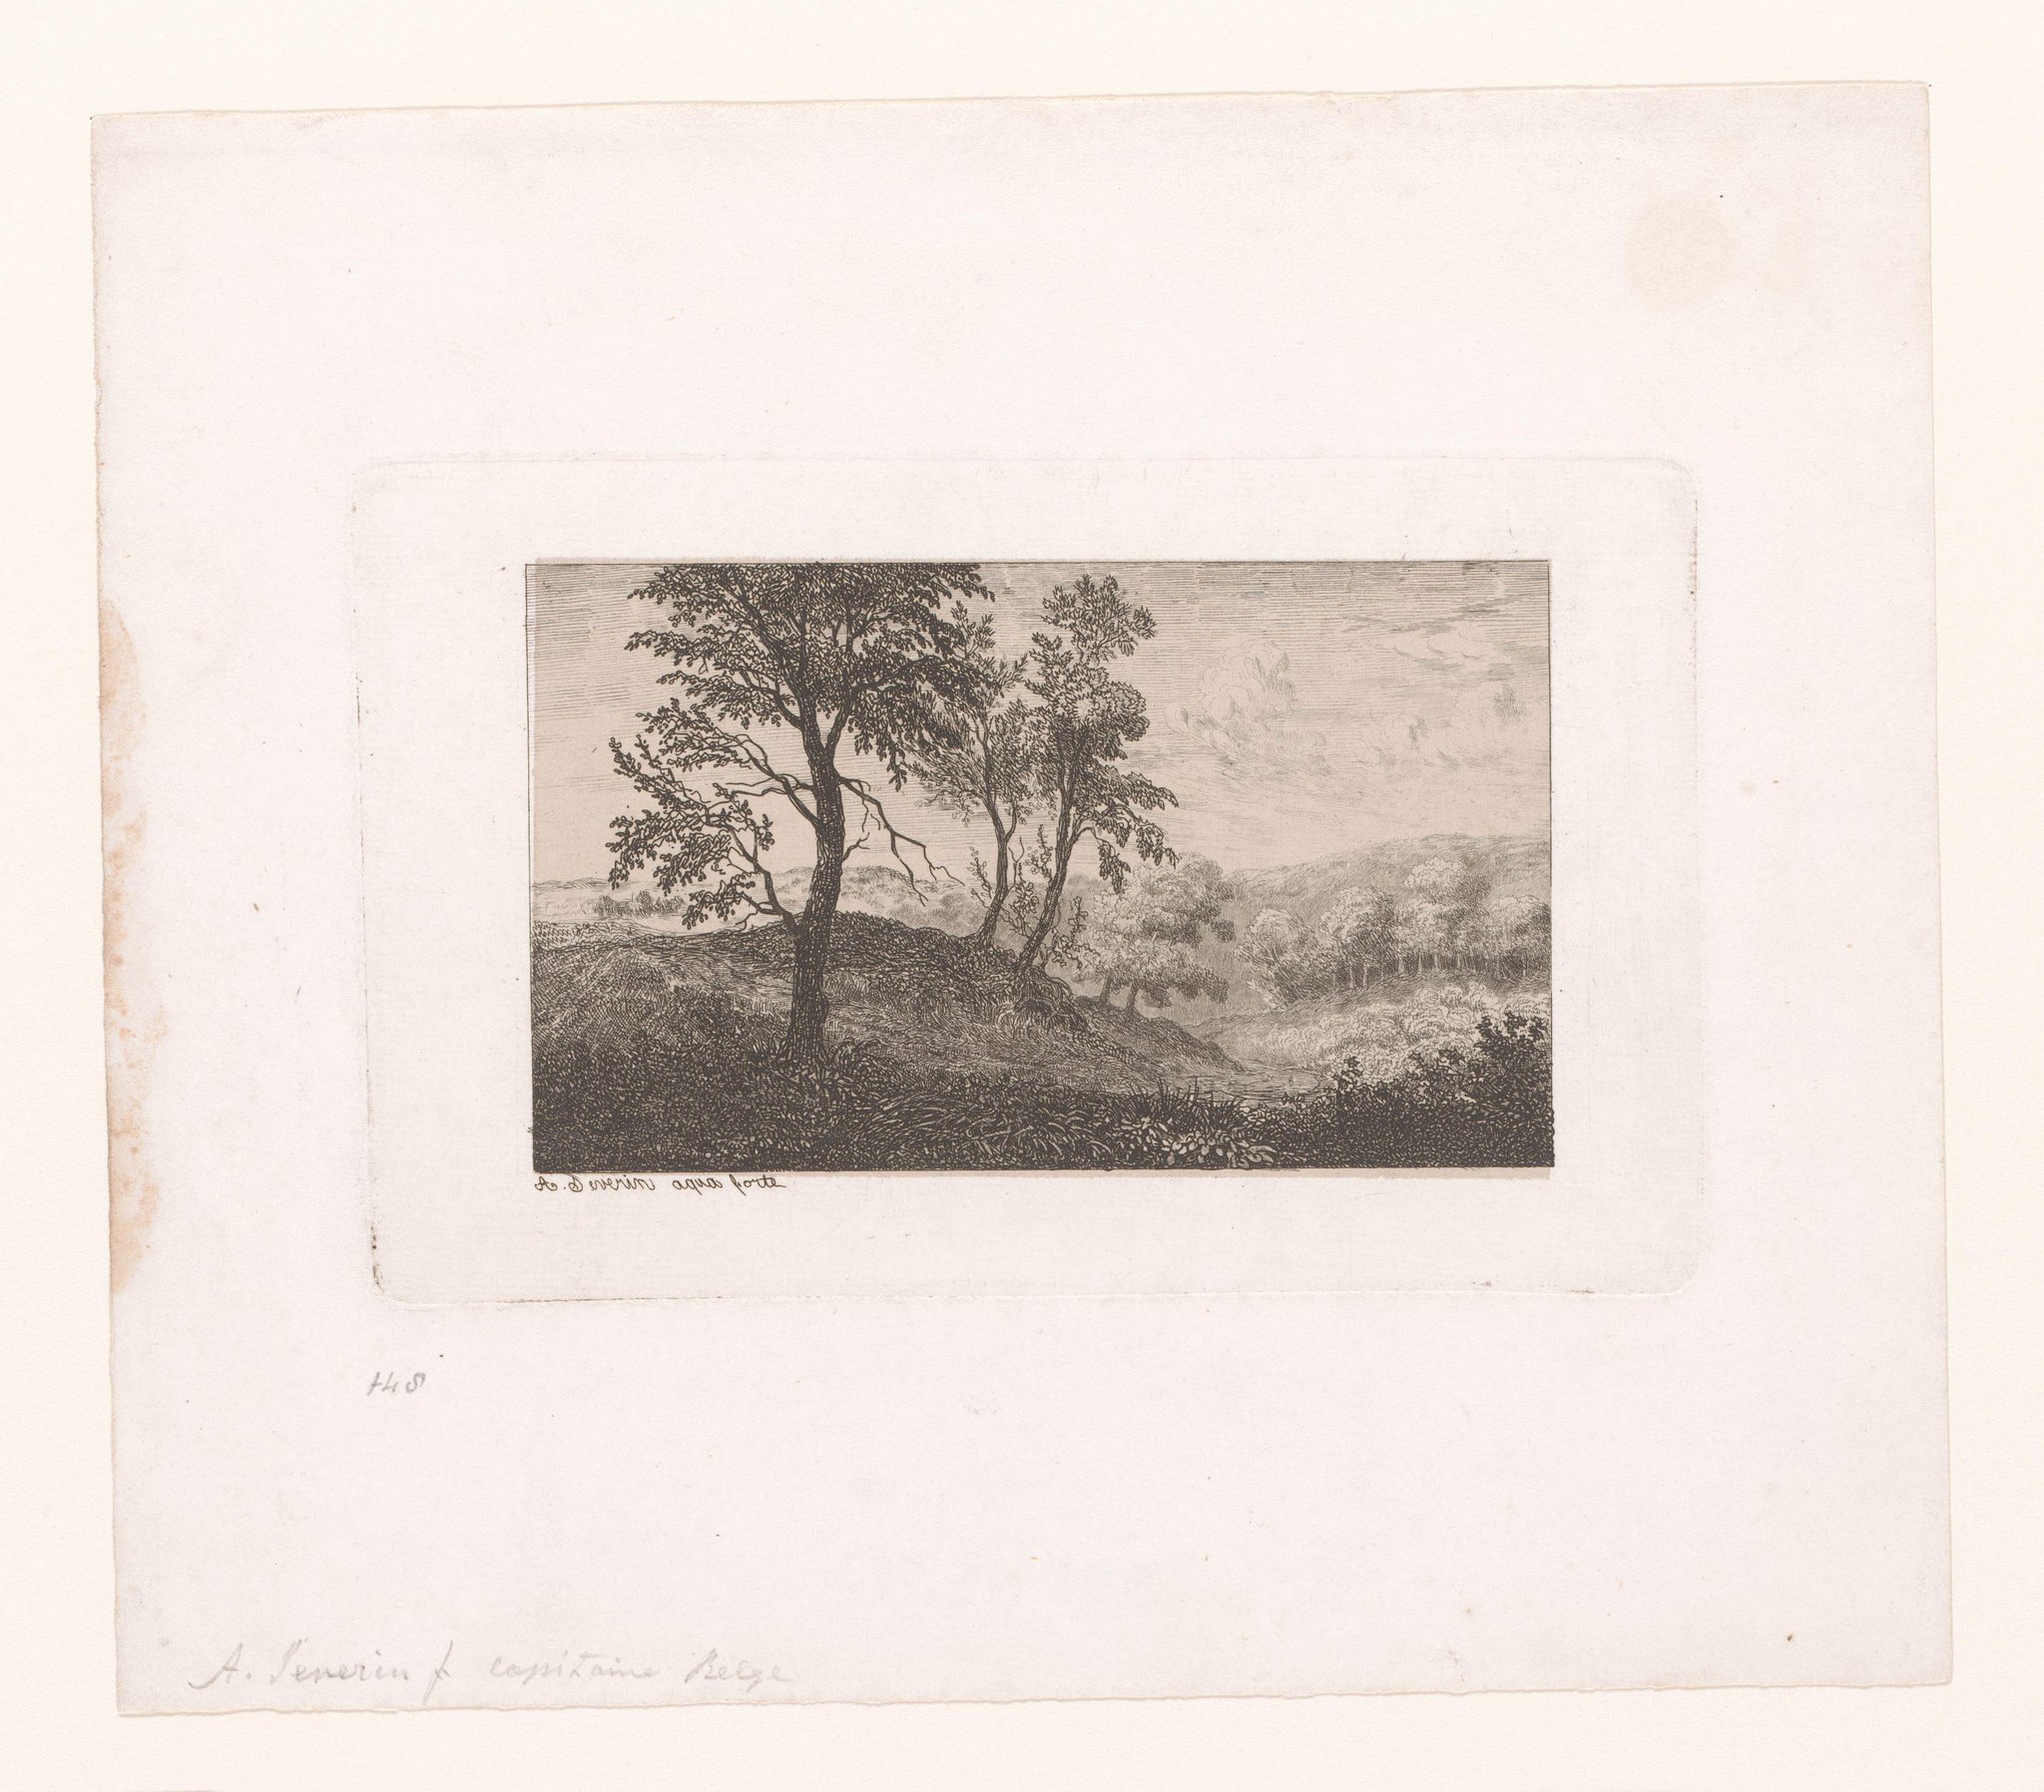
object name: print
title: Landschap met bomen op een heuvel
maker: antoine severin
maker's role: print maker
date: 1851-1852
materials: paper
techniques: drypoint, etching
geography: brussels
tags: low hill country, trees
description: Prent maakt deel uit van een serie van negen prenten.